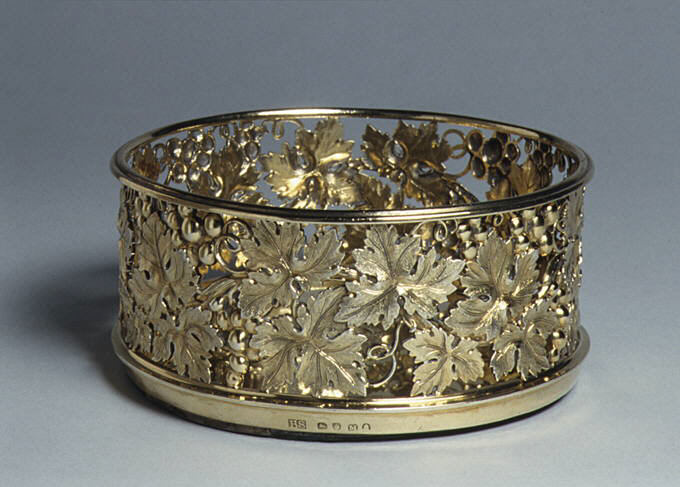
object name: coaster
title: Pair of coasters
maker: benjamin smith, ii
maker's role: maker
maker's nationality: british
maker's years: 1764-1823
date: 1807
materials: silver gilt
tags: flowers